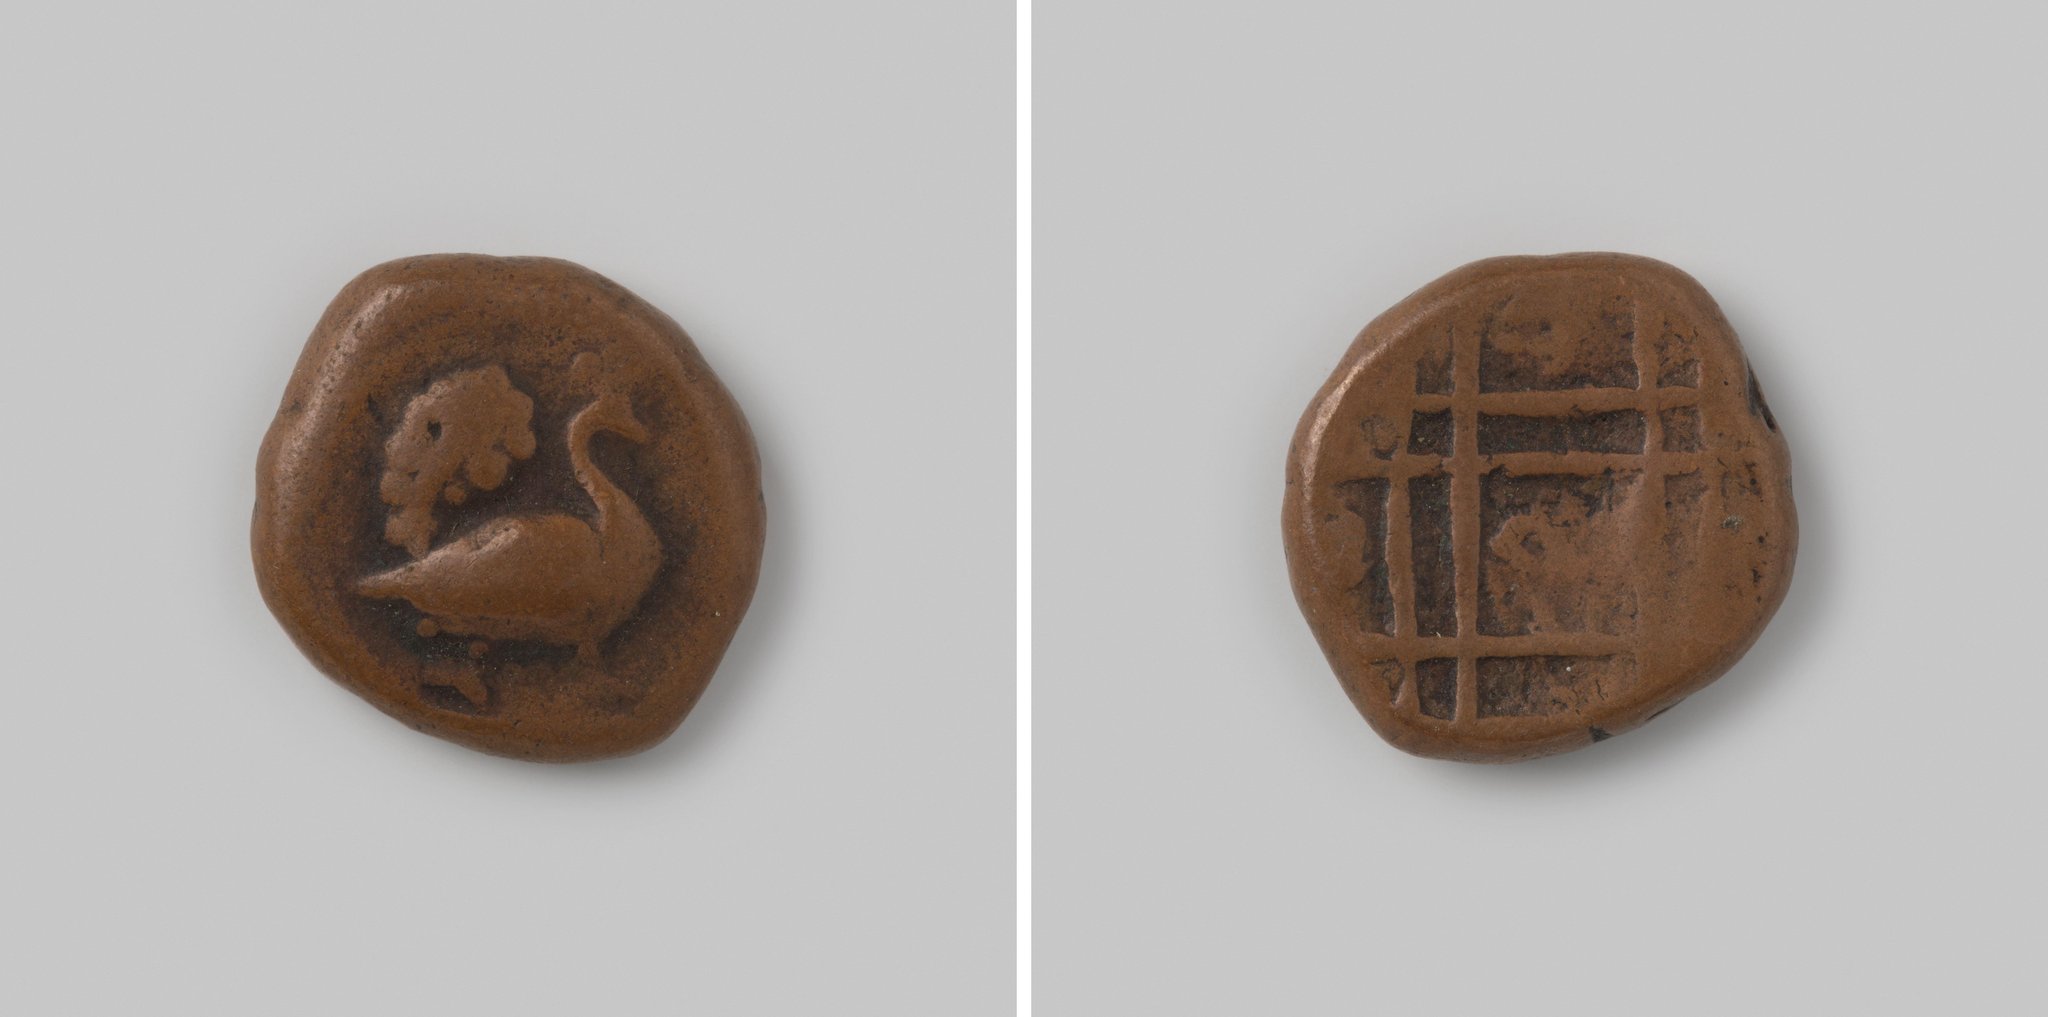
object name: coin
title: Akhtar uit Mysore in India van Kanthirava Narasa raja Wodeyar I, 1638-1659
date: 1638-1659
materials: copper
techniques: striking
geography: mysore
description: Koperen munt. Voorzijde: lopende pauw met uitgezette veren naar rechts. Keerzijde: patroon van loodrechtop elkaar staande rechte lijnen, waarbinnen twee cirkels.